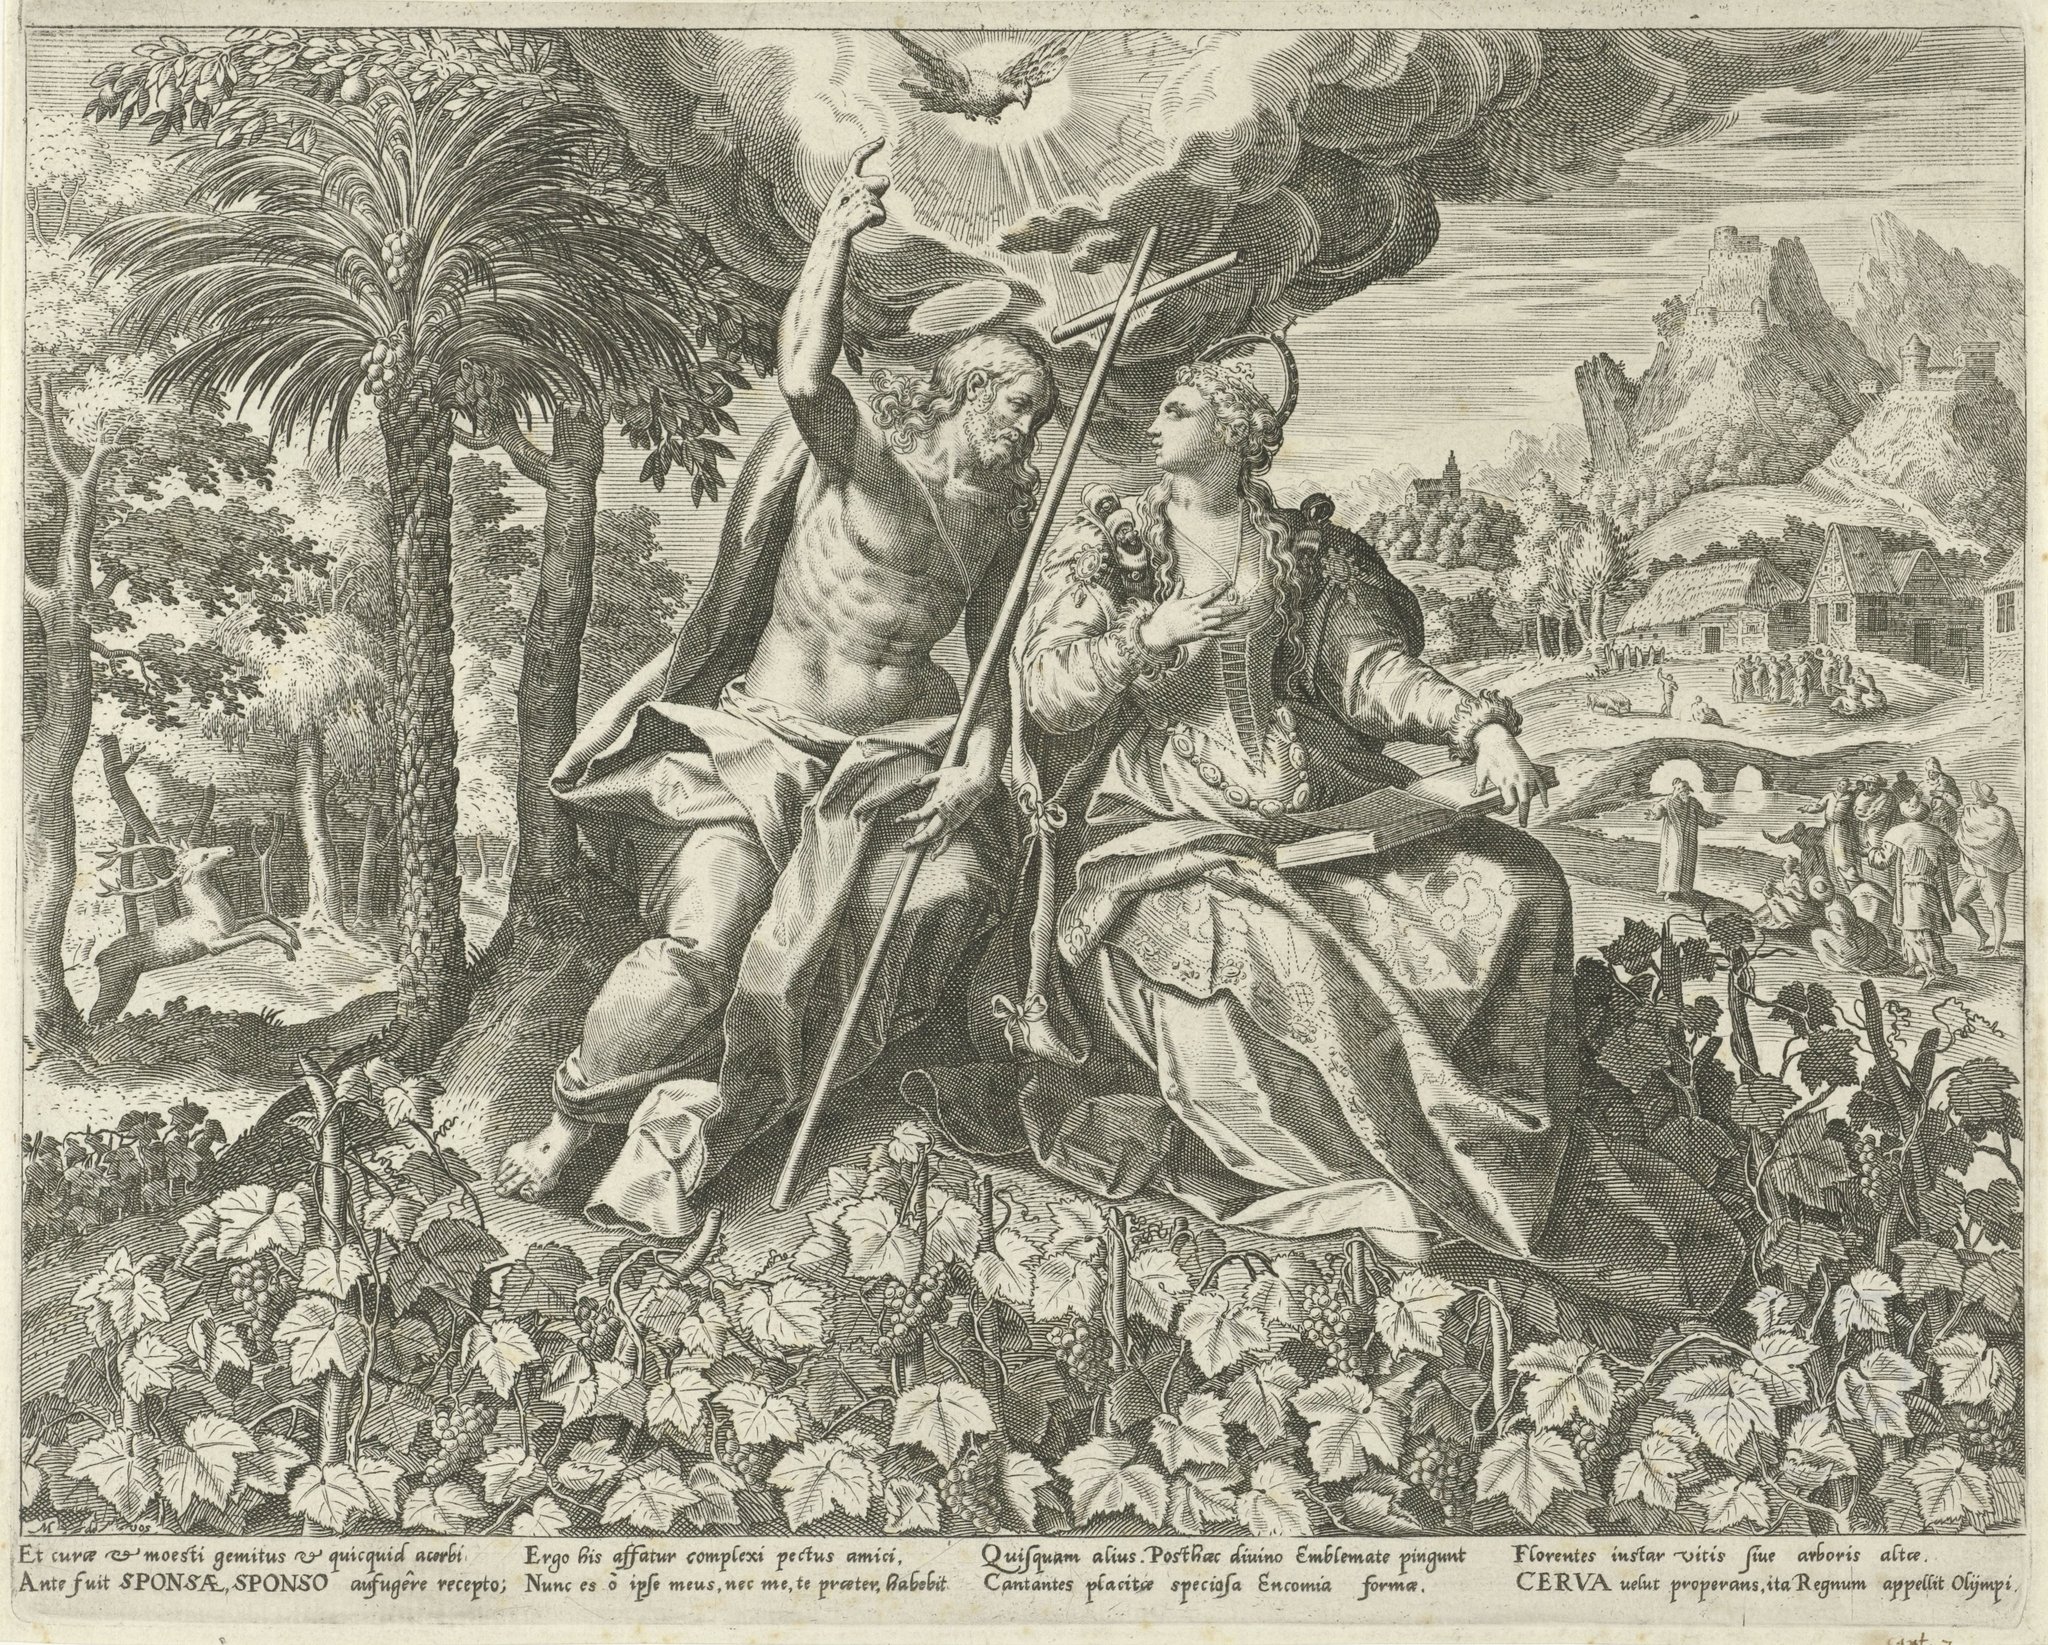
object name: print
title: Hooglied van Salomo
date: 1590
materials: paper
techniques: engraving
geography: antwerp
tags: vine, 'ecclesia' as bride of christ (the lamb), 'ecclesia sponsa dei', 'sponsus-sponsa', song of solomon, song of songs (with book chapter:verse) (+ holy ghost (song of sol. 4:1)), song of solomon, song of songs (with book chapter:verse) (+ christ bearded), garden, hoofed animals: stag, preaching (in general)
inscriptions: collector's mark: Lugt 11, collector's mark: Lugt 10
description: Christus en zijn bruid, zittend in een landschap met wijnranken op de voorgrond. Christus wijst naar boven waar de Heilige Geest in de gedaante van een duif te zien is. Linksachter dadelpalmen en een hert. Rechts op de achtergrond luistert een menigte naar een preek. De prent heeft een Latijns onderschrift over het hooglied van Salomo en is de vierde prent van een zesdelige serie.